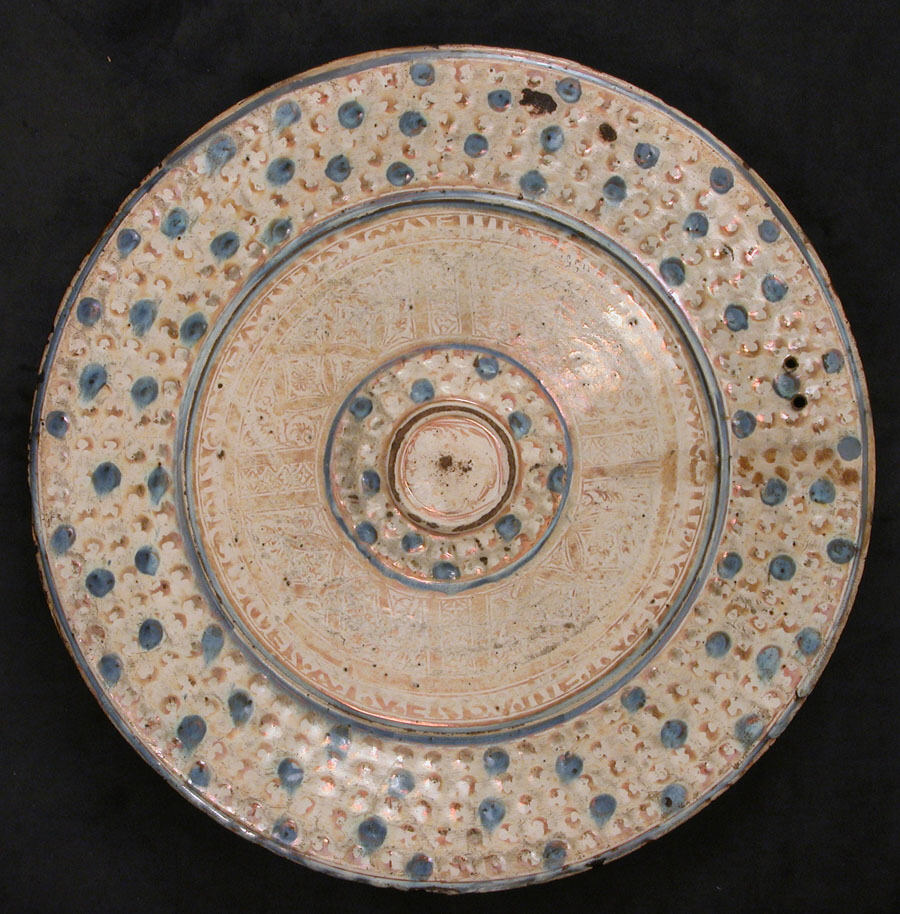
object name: dish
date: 1401-1600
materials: earthenware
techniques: luster painting, glazing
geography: spain